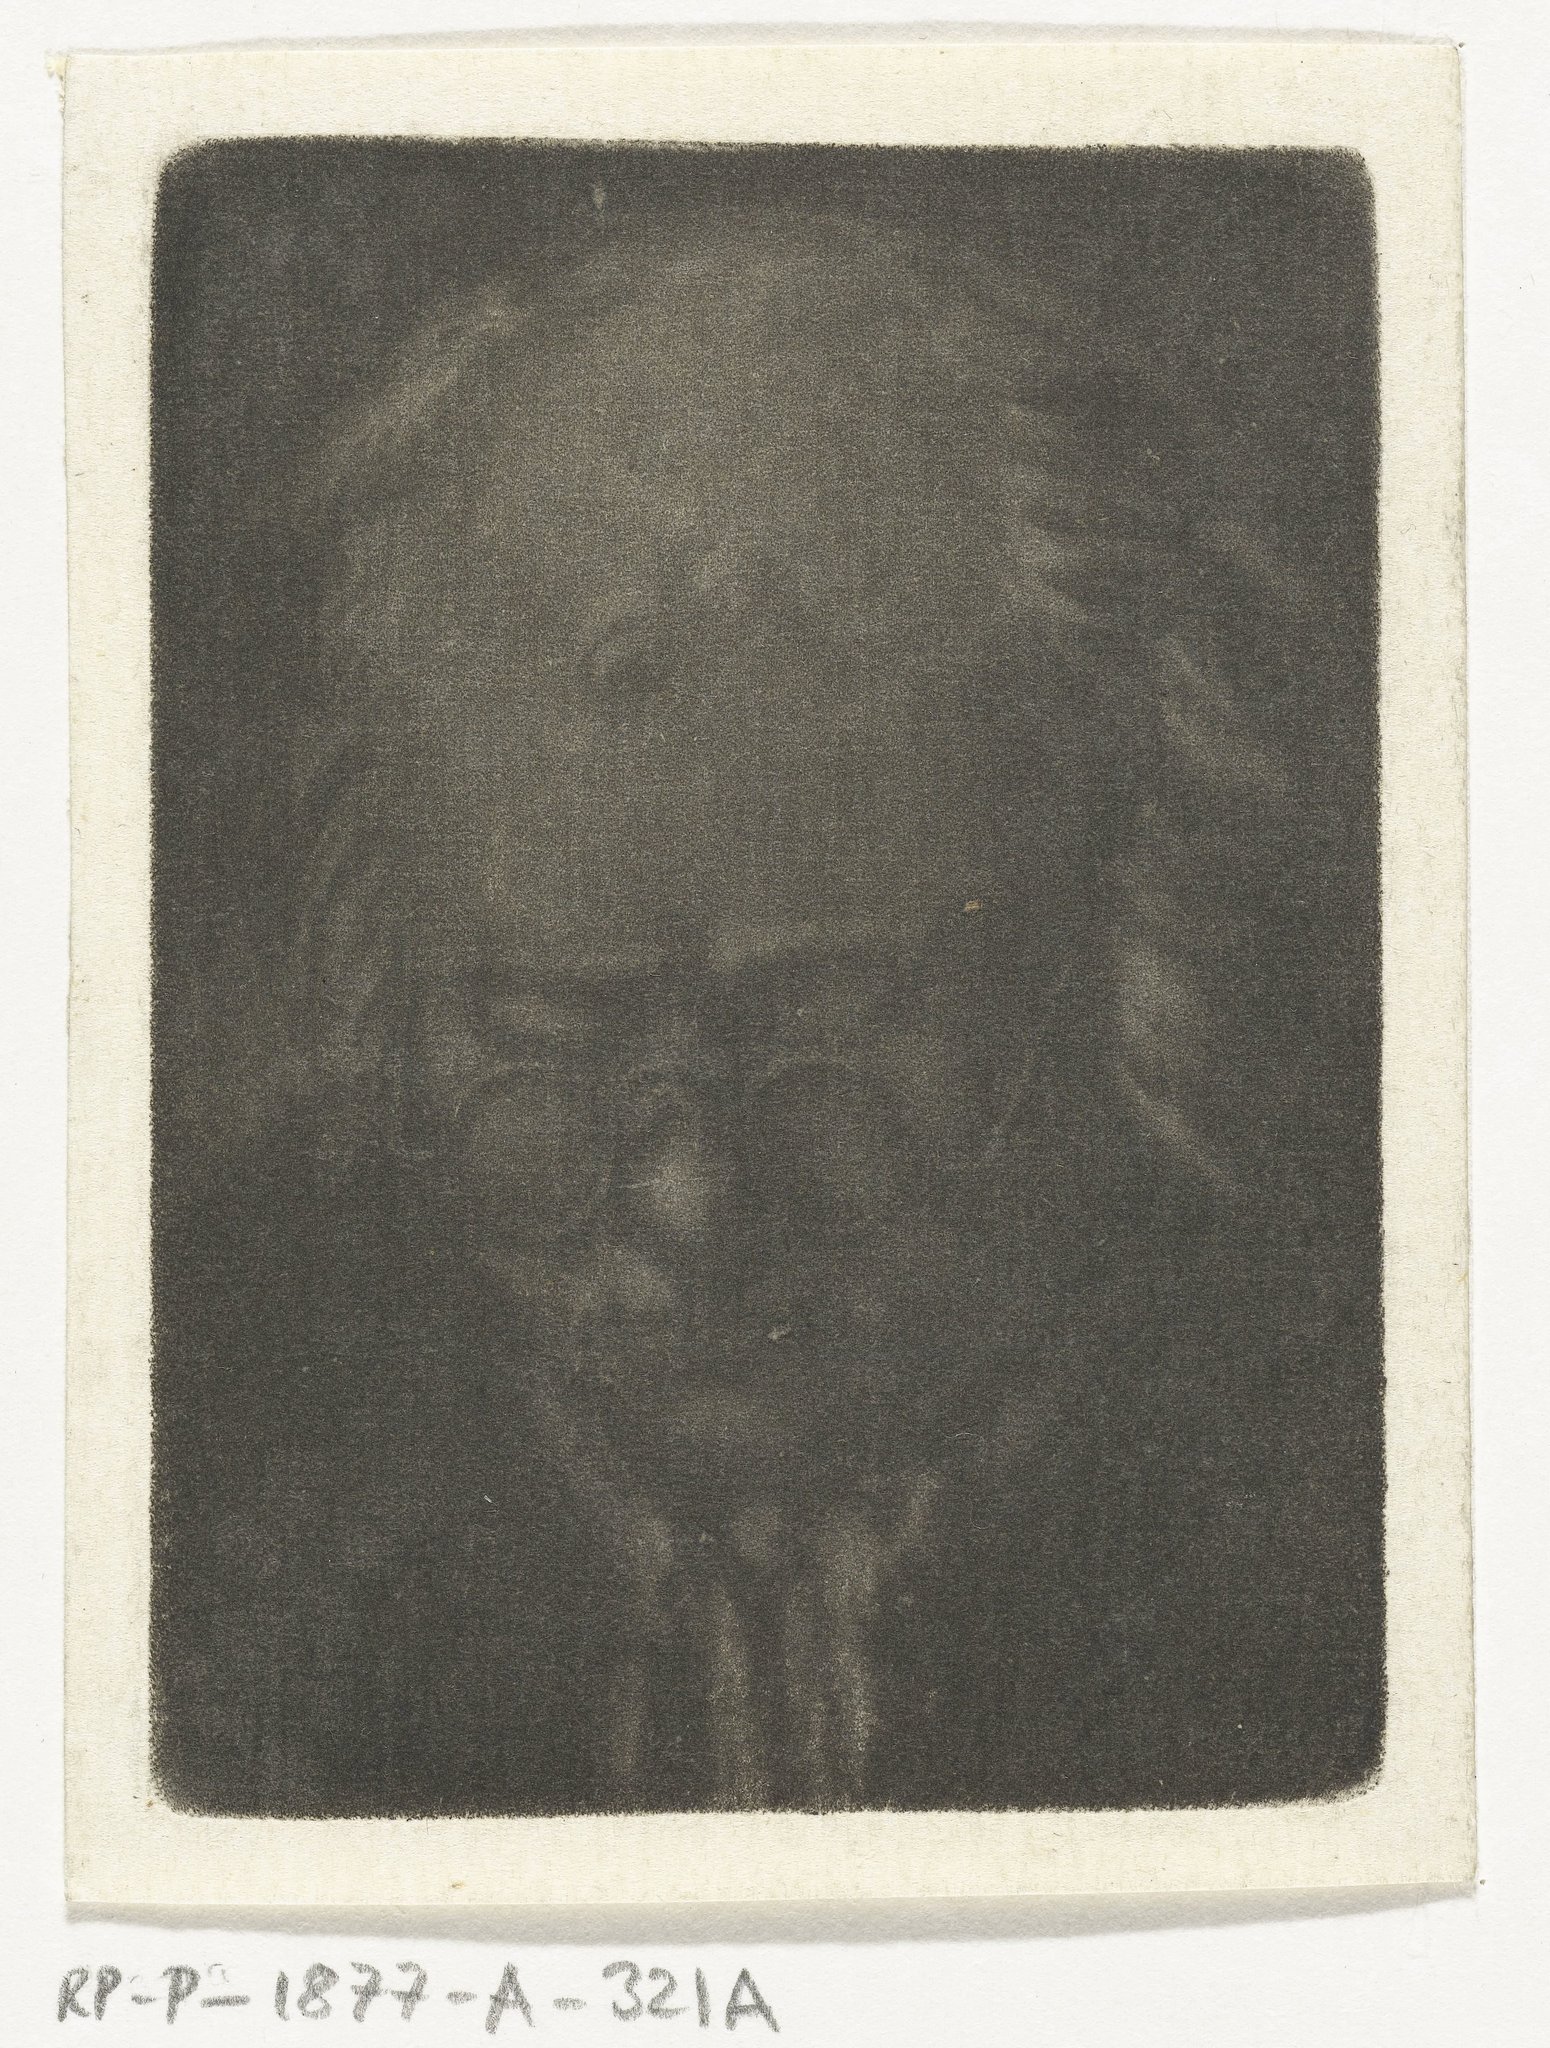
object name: print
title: Hoofd van een man met een bril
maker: anthonie van den bos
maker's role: draughtsman, print maker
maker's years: 1763-1838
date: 1778-1838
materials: paper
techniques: aquatint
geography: netherlands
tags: eyeglasses, spectacles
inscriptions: collector's mark: Lugt 2228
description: Borstbeeld van een oude man met kaal hoofd en een brilletje.